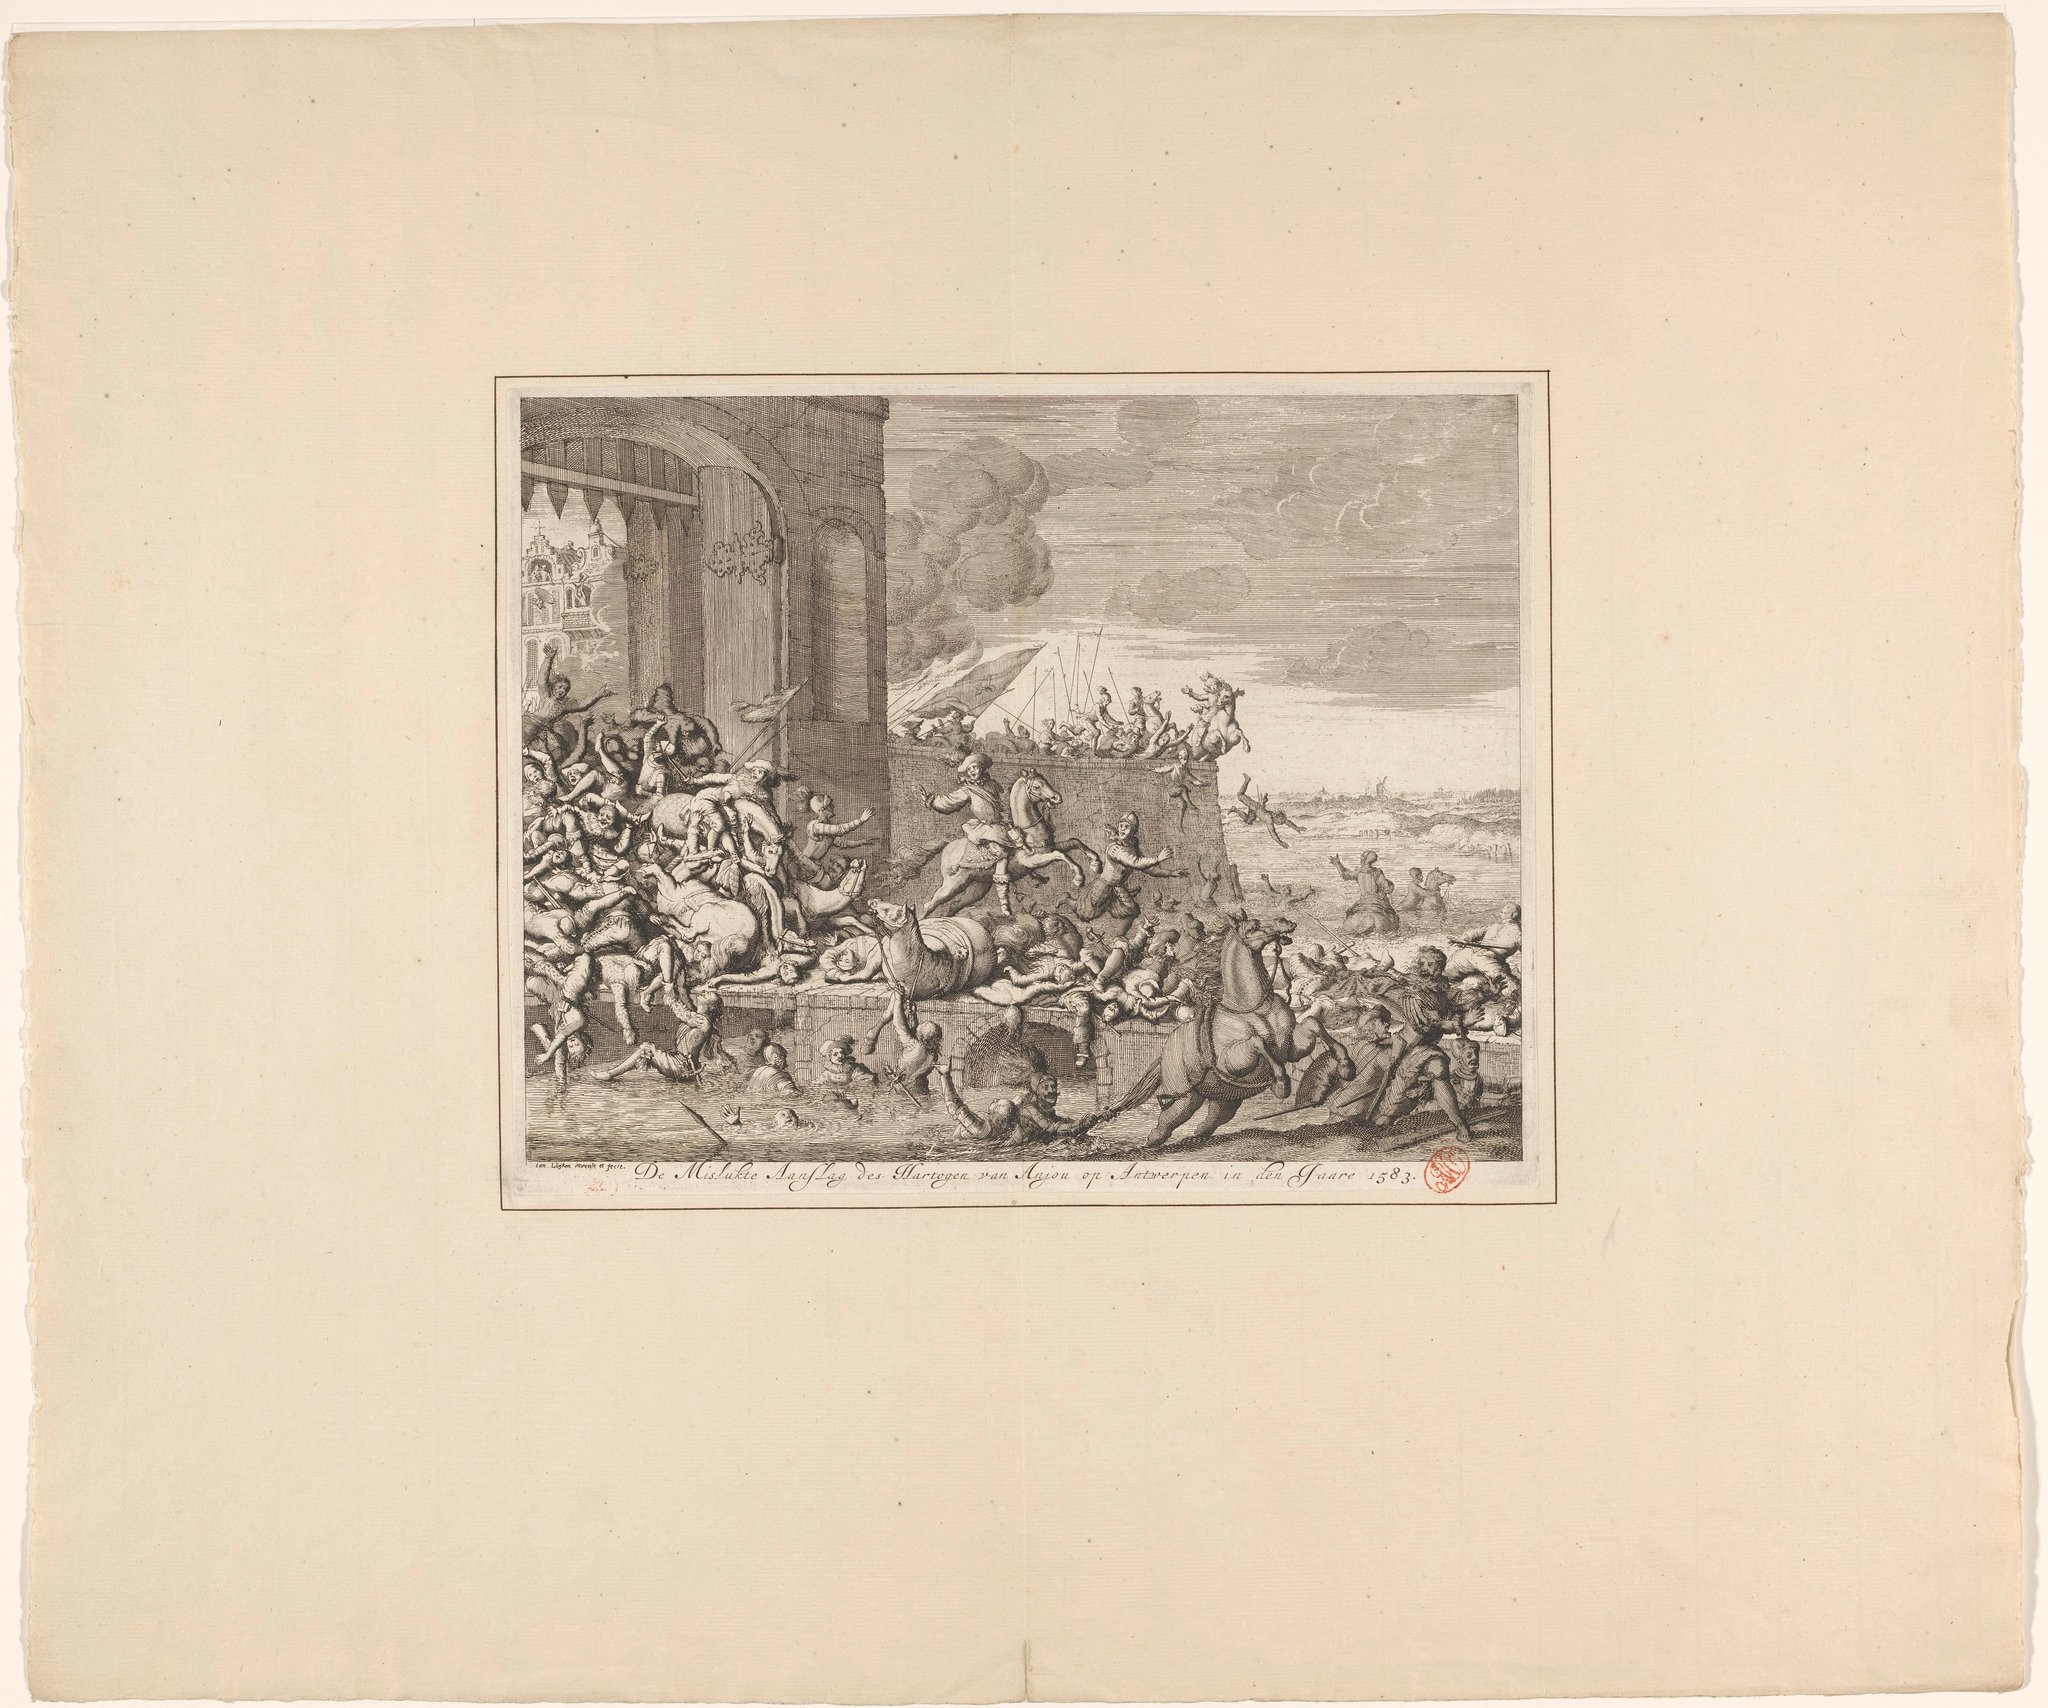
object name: book illustration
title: De mislukte aanslag des hartogen van Anjou op Antwerpen in den jaare 1583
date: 1679-1690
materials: paper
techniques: engraving, etching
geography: amsterdam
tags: paris, françois-hercule de valois (hertog van anjou), counter-attack, plundering ~ soldiers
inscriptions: collector's mark: Lugt 195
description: Prent ook gebruikt in: Bor Christiaansz, Pieter. Oorsprongk, begin, en vervolgh der Nederlandsche oorlogen, 4 delen. Amsterdam: weduwe Joannes van Someren, Abraham Wolfgang, Hendrick en Dirk Boom, 1679-1684, dl. 2, p. 342. En in: Leti, Gregorio. Teatro Belgico o vero ritratti historici, chronologici, politici e geografici delle Sette Provincie Unite. 2 delen. Amsterdam: Willem de Jonge, 1690, dl. 1, p. 86-87. En in: Groot, Hugo de. Nederlandtsche Jaerboeken en Historien (…). Amsterdam: weduwe Joannes van Someren, Abraham Wolfgang en Hendrick en Dirk Boom, 1681, p. 82-83.